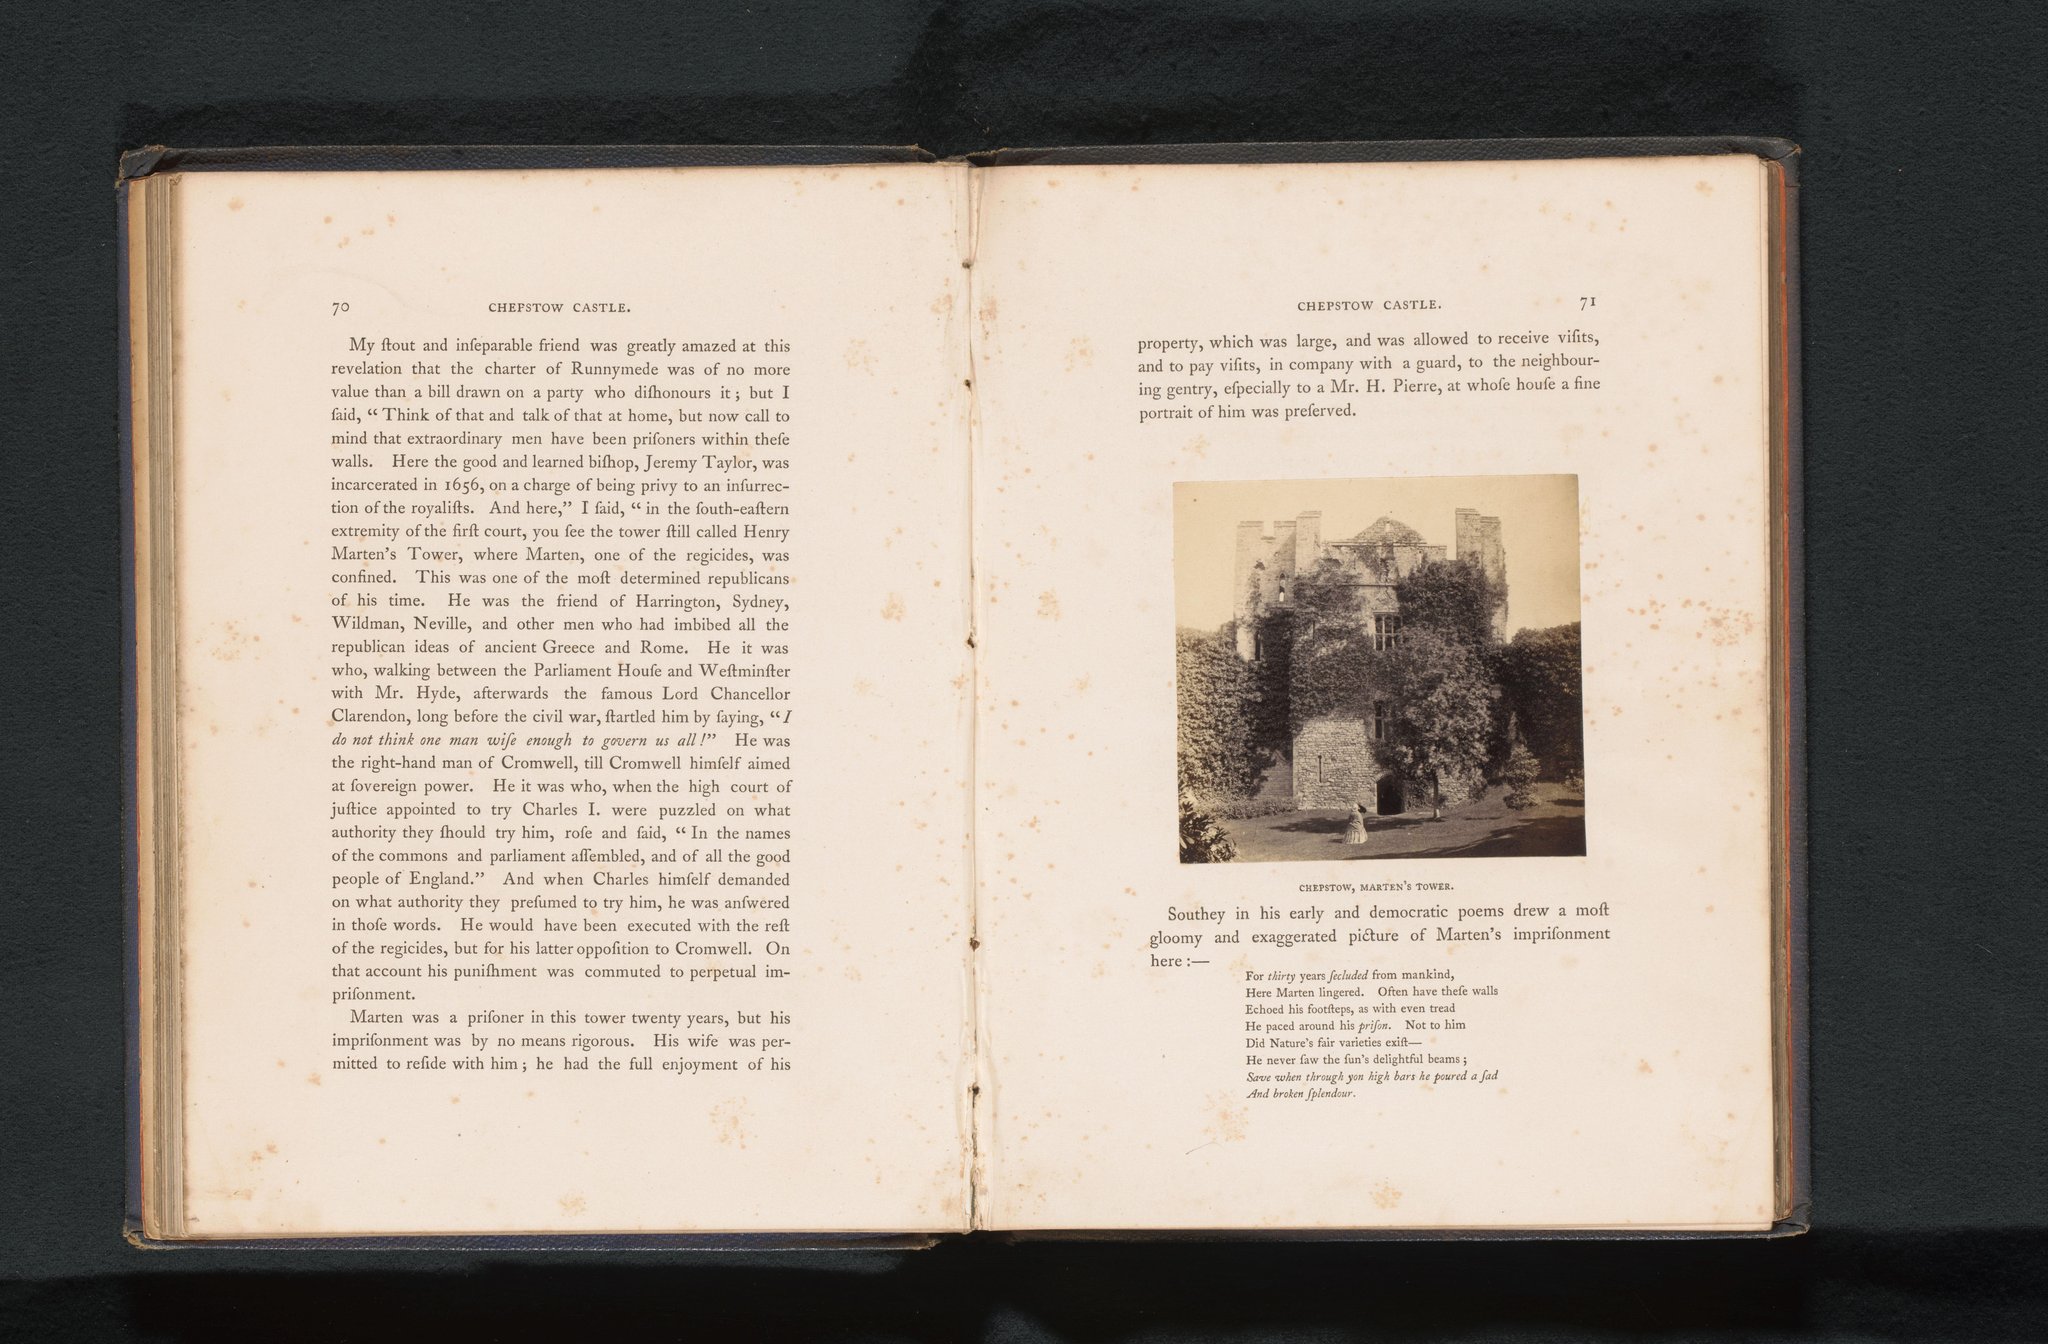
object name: page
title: Chepstow, Marten's Tower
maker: francis bedford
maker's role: print maker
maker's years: 1815-1894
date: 1857-1862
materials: photographic support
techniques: albumen print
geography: chepstow castle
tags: ruin of a dwelling, house, castle, etc.